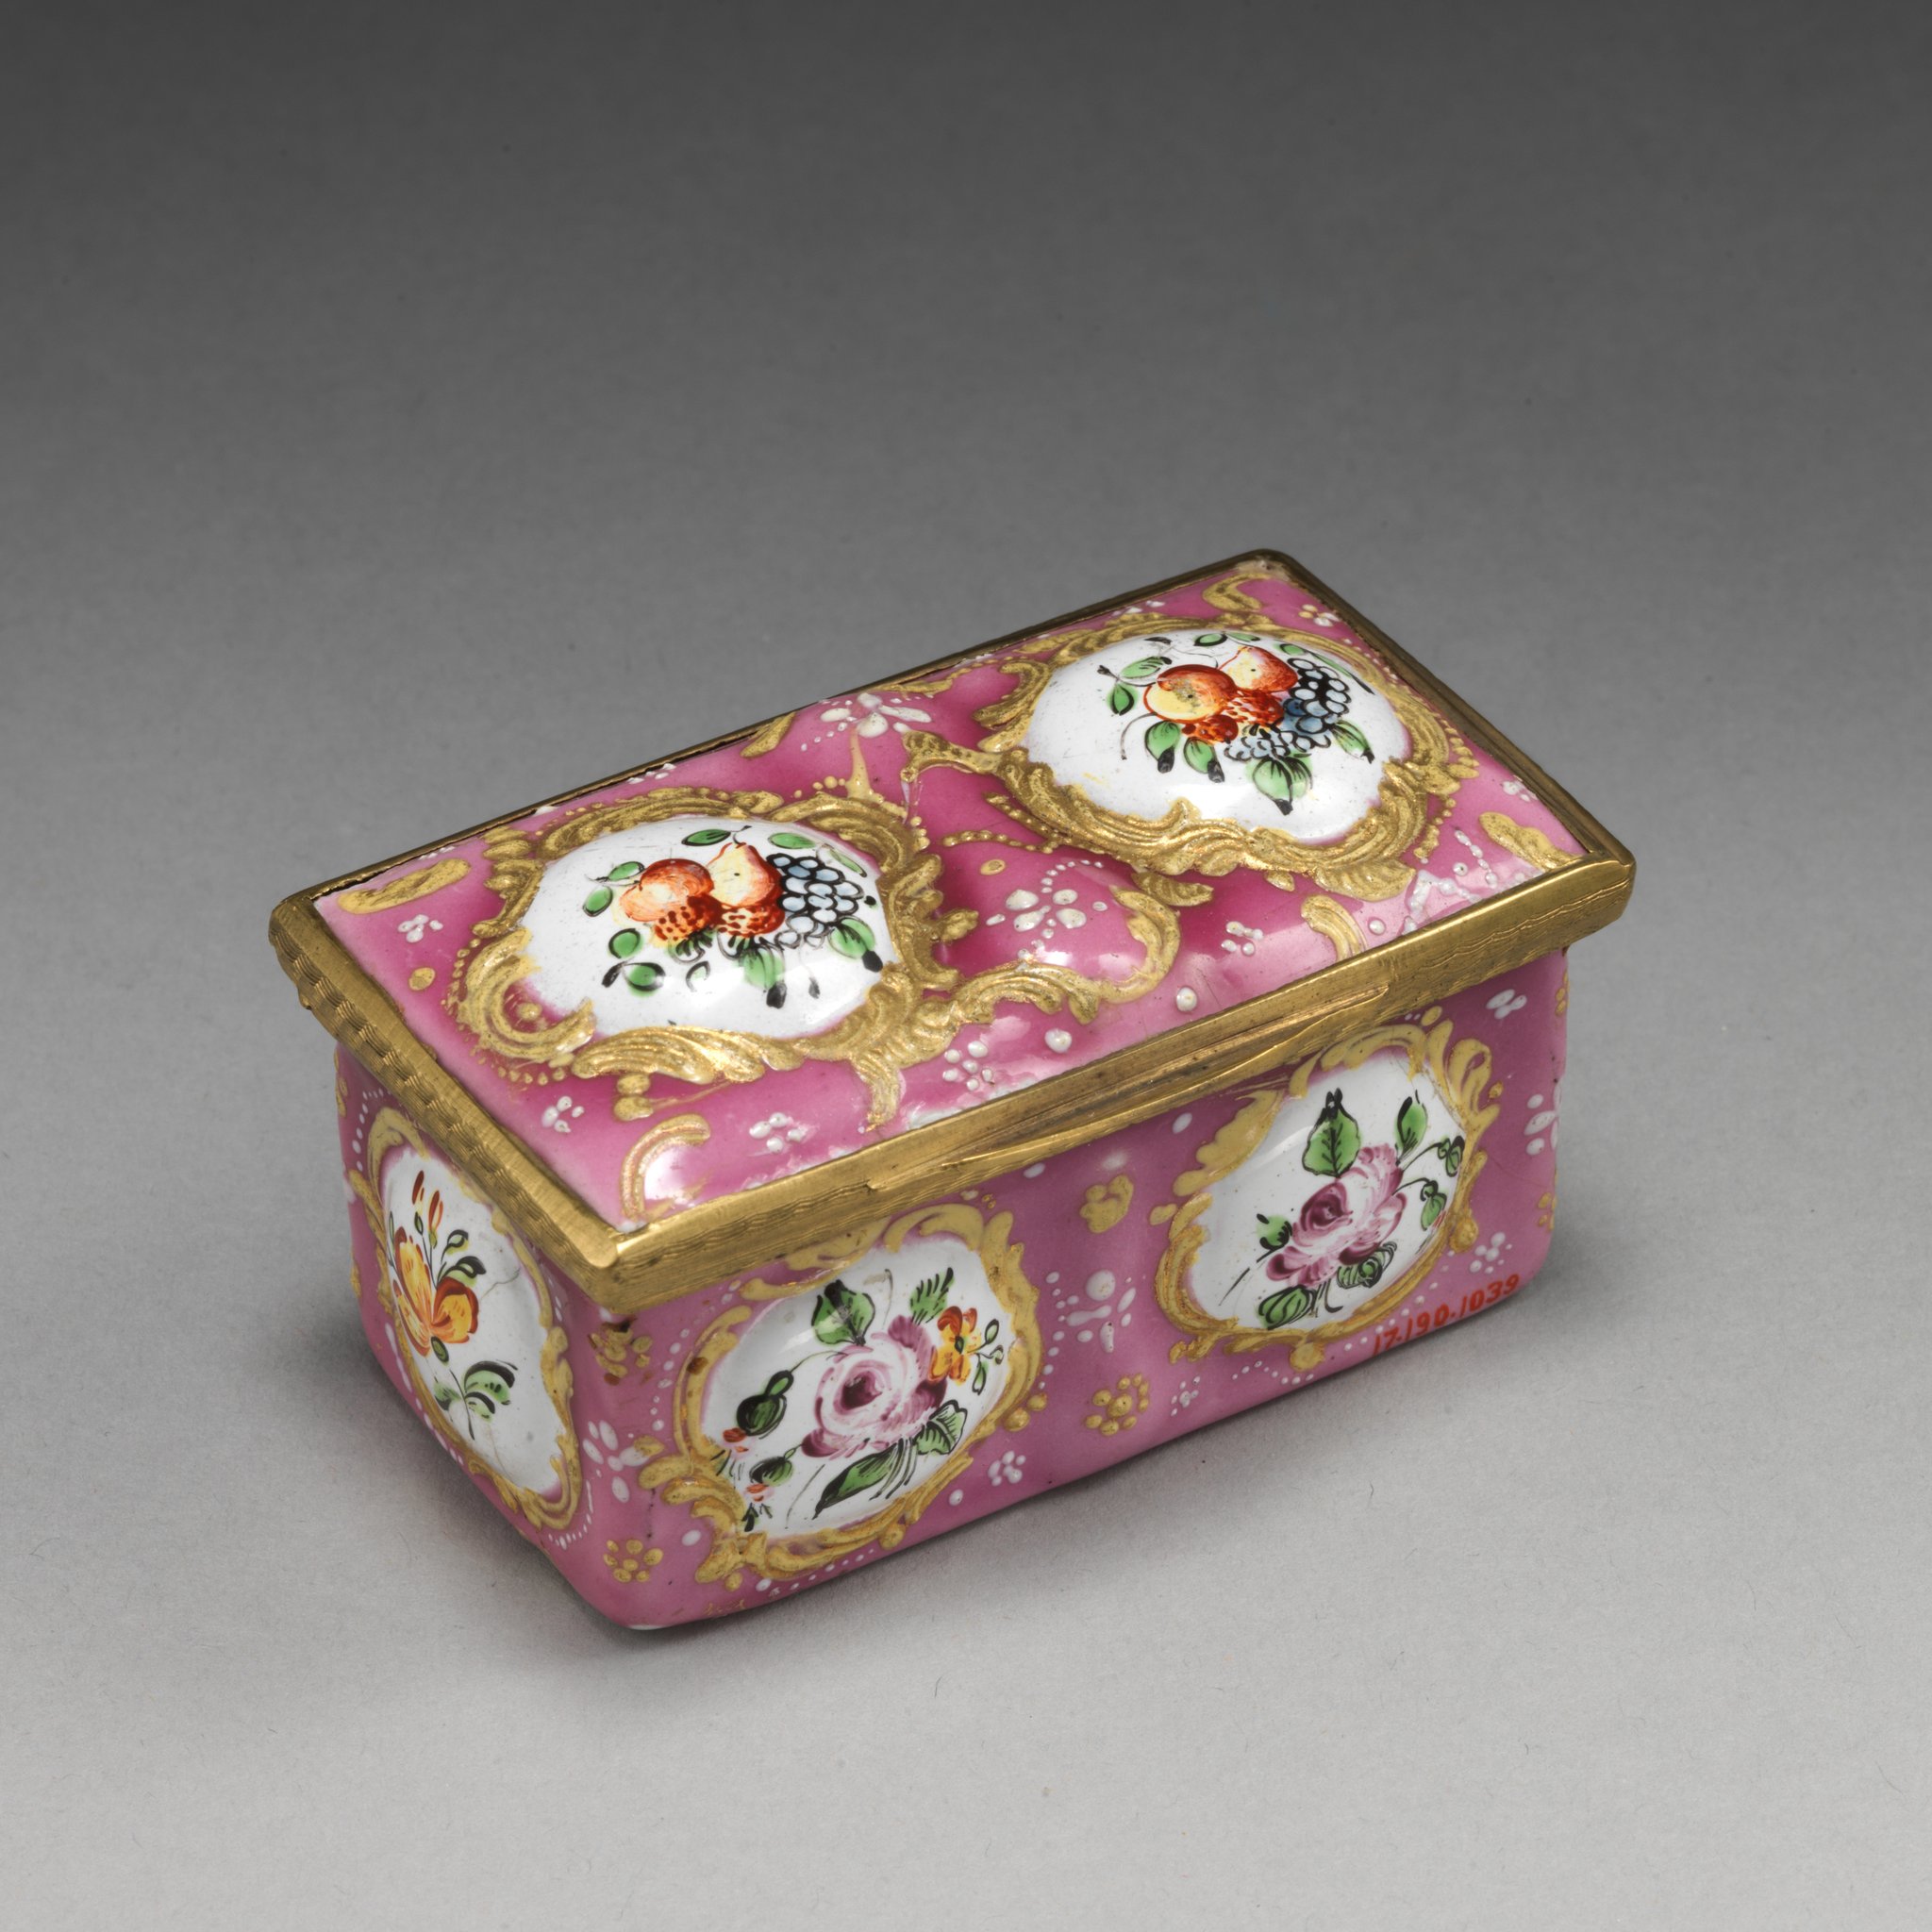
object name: snuffbox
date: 1770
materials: copper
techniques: enamel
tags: flowers,leaves